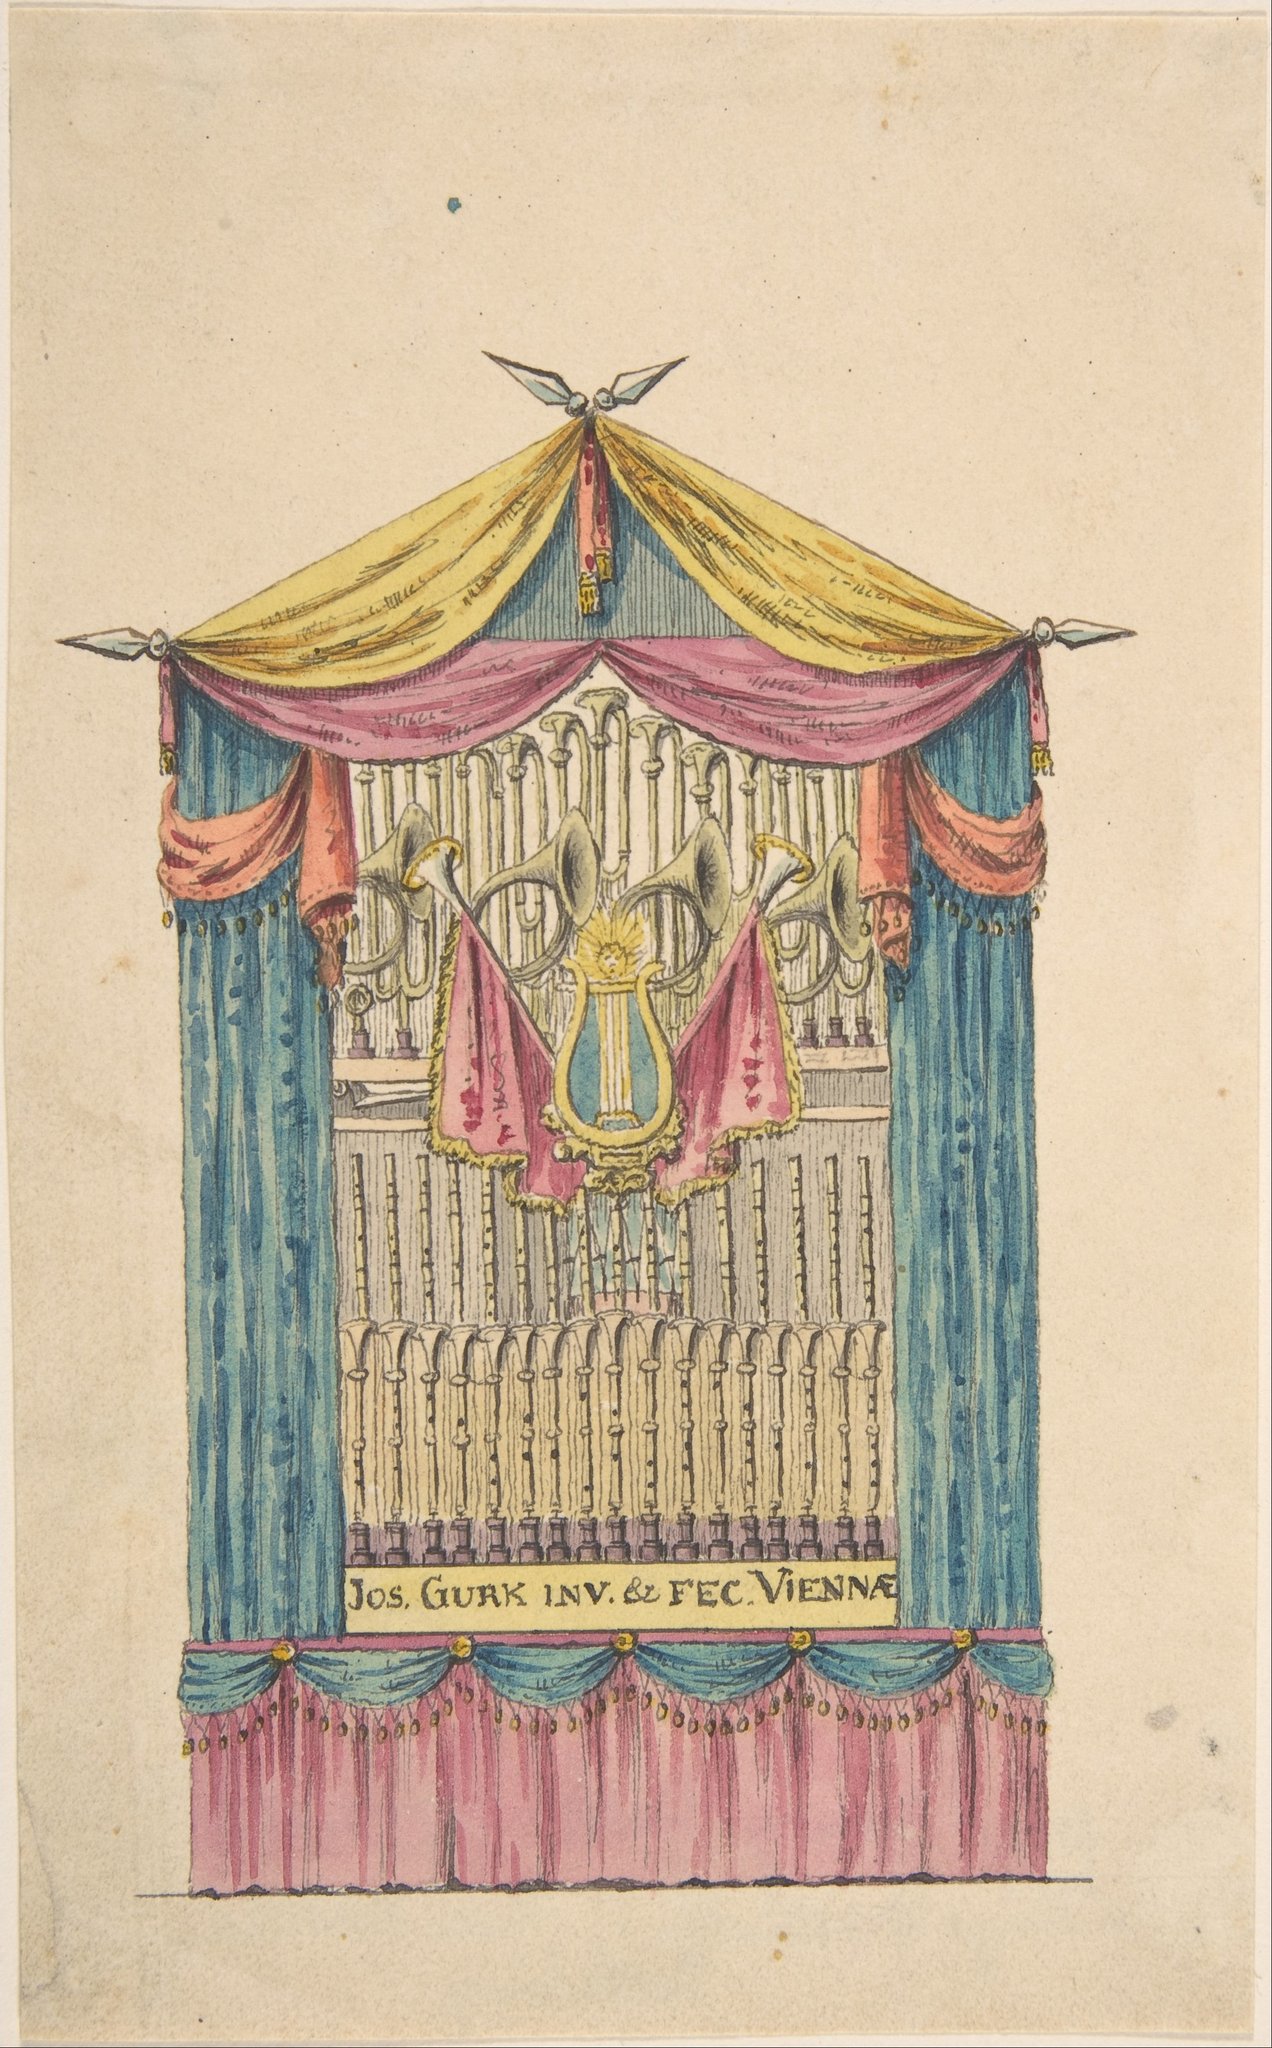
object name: drawing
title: Design for a Fanciful Organ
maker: joseph ignaz gurk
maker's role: artist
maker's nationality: austrian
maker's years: 1795-1826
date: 1767-1833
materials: ink, watercolor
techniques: pen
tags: musical instruments